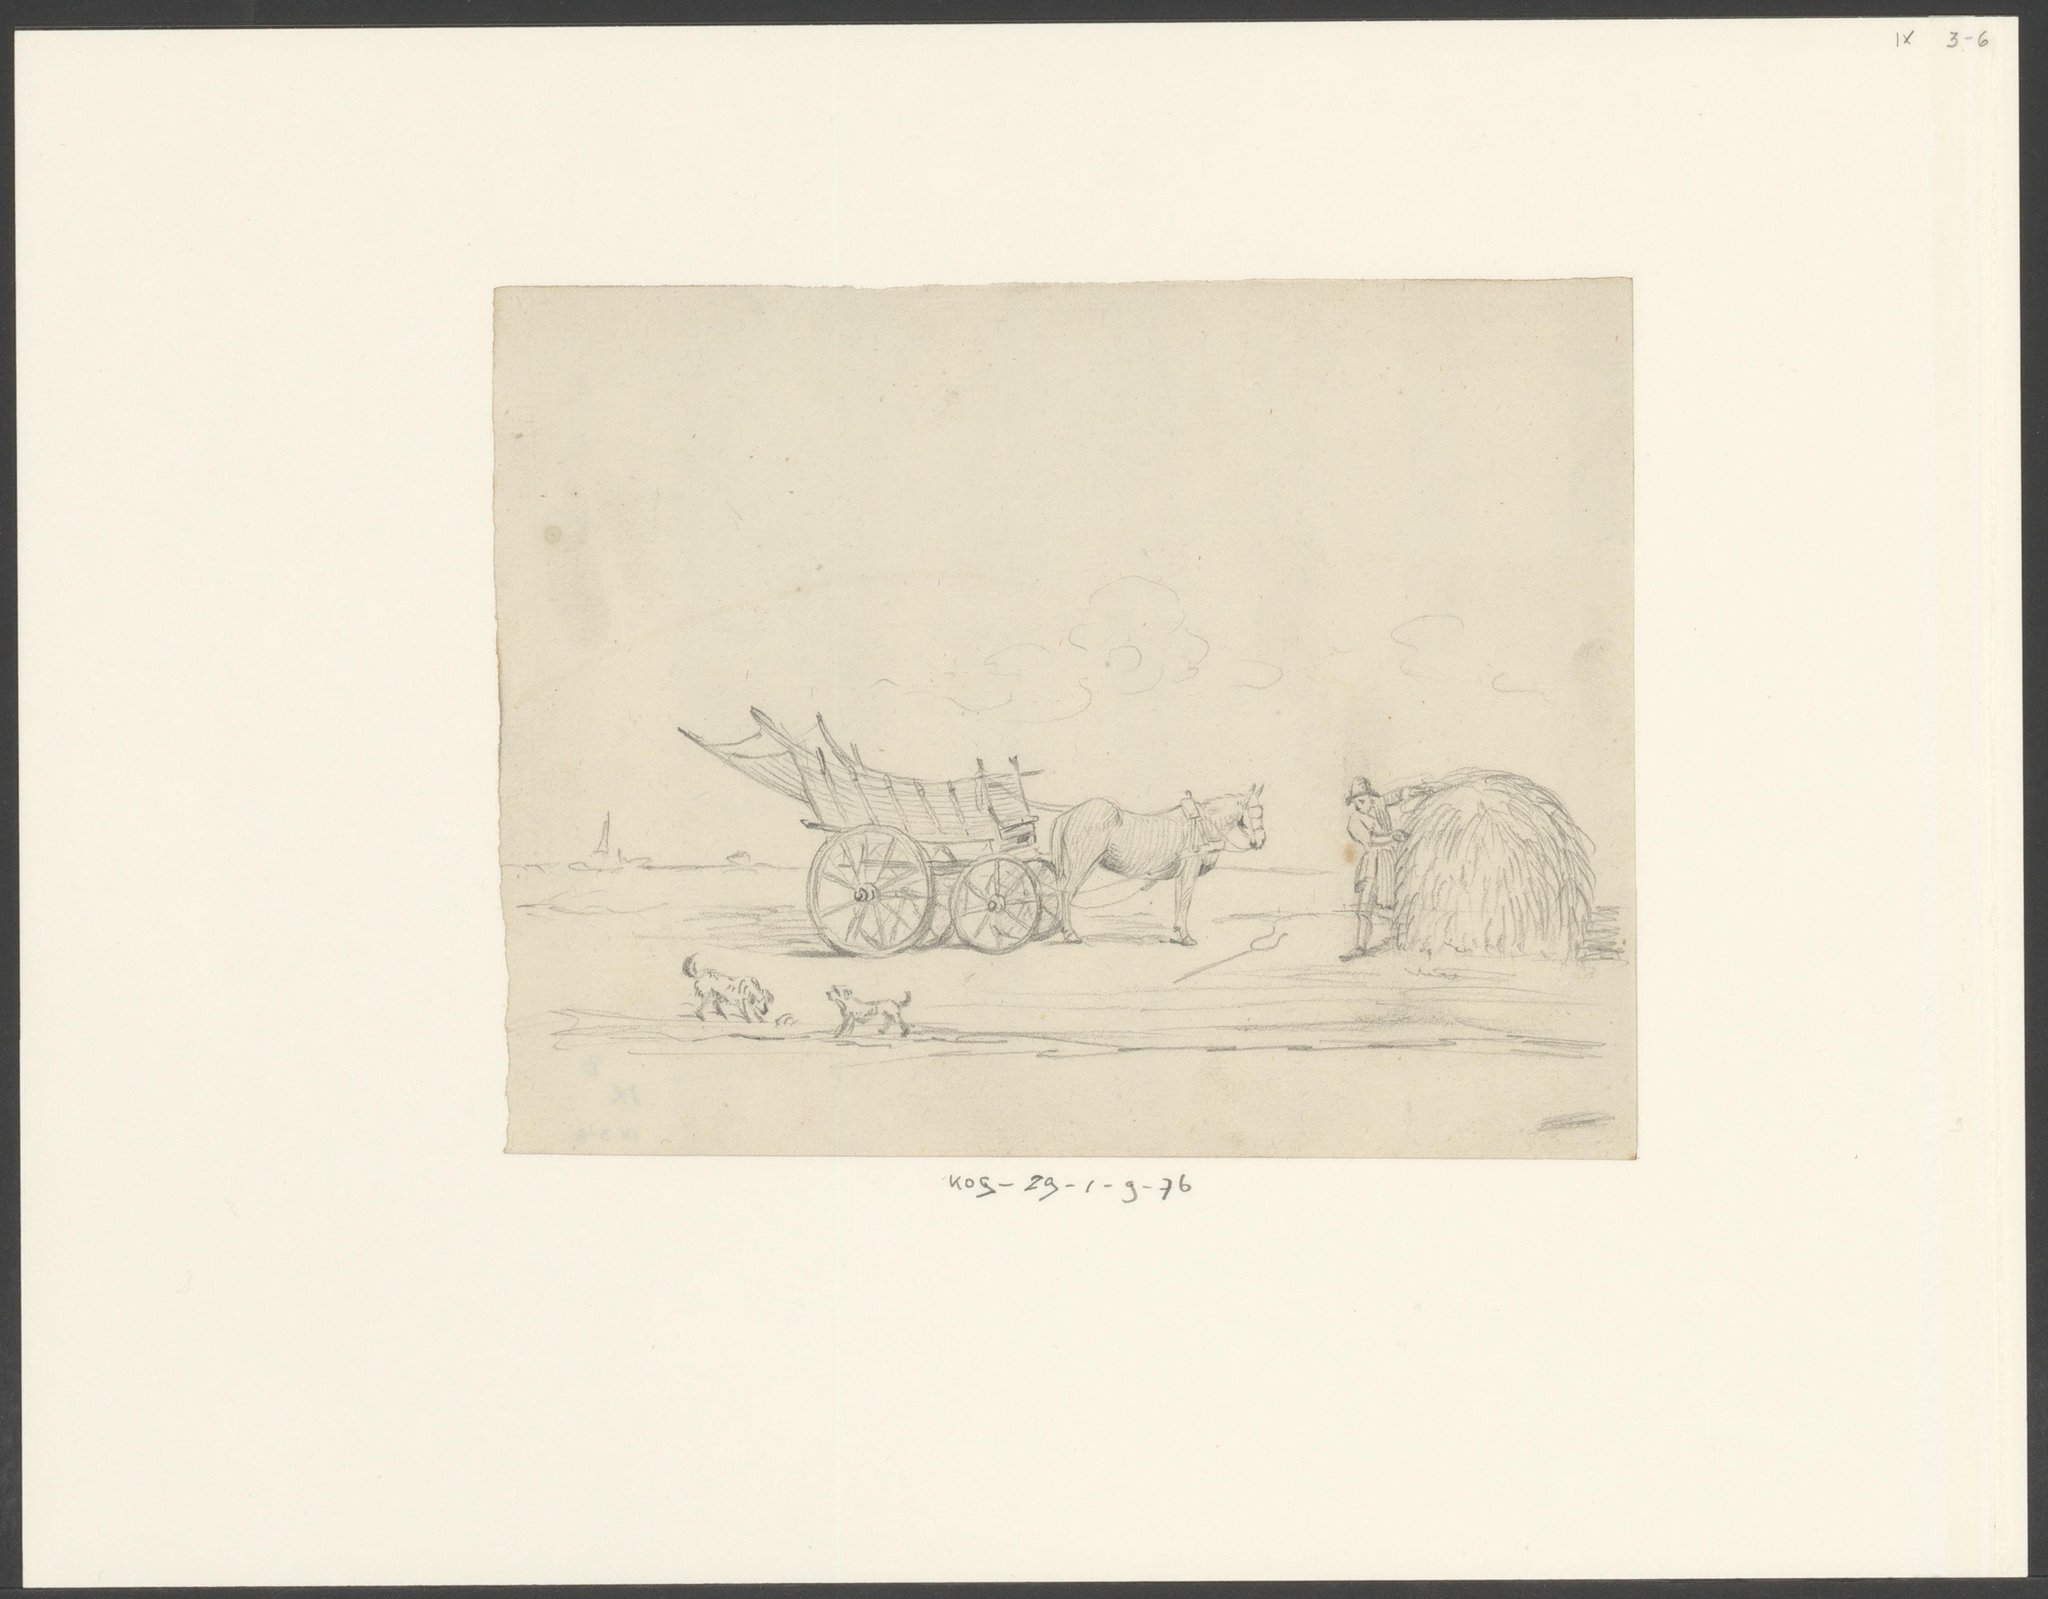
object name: drawing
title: Laden van een hooiwagen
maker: Anonymous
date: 1800-1899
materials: paper, pencil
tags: hay-wagon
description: Paard staat aangespannen aan een hooiwagen. Een boer staat bij een hooiberg, klaar om de wagen in te laden. Onderwerpsrubrieken binnen de Atlas Zeden en Gewoonten: Handel, nijverheid en verkeer, Landbouw.